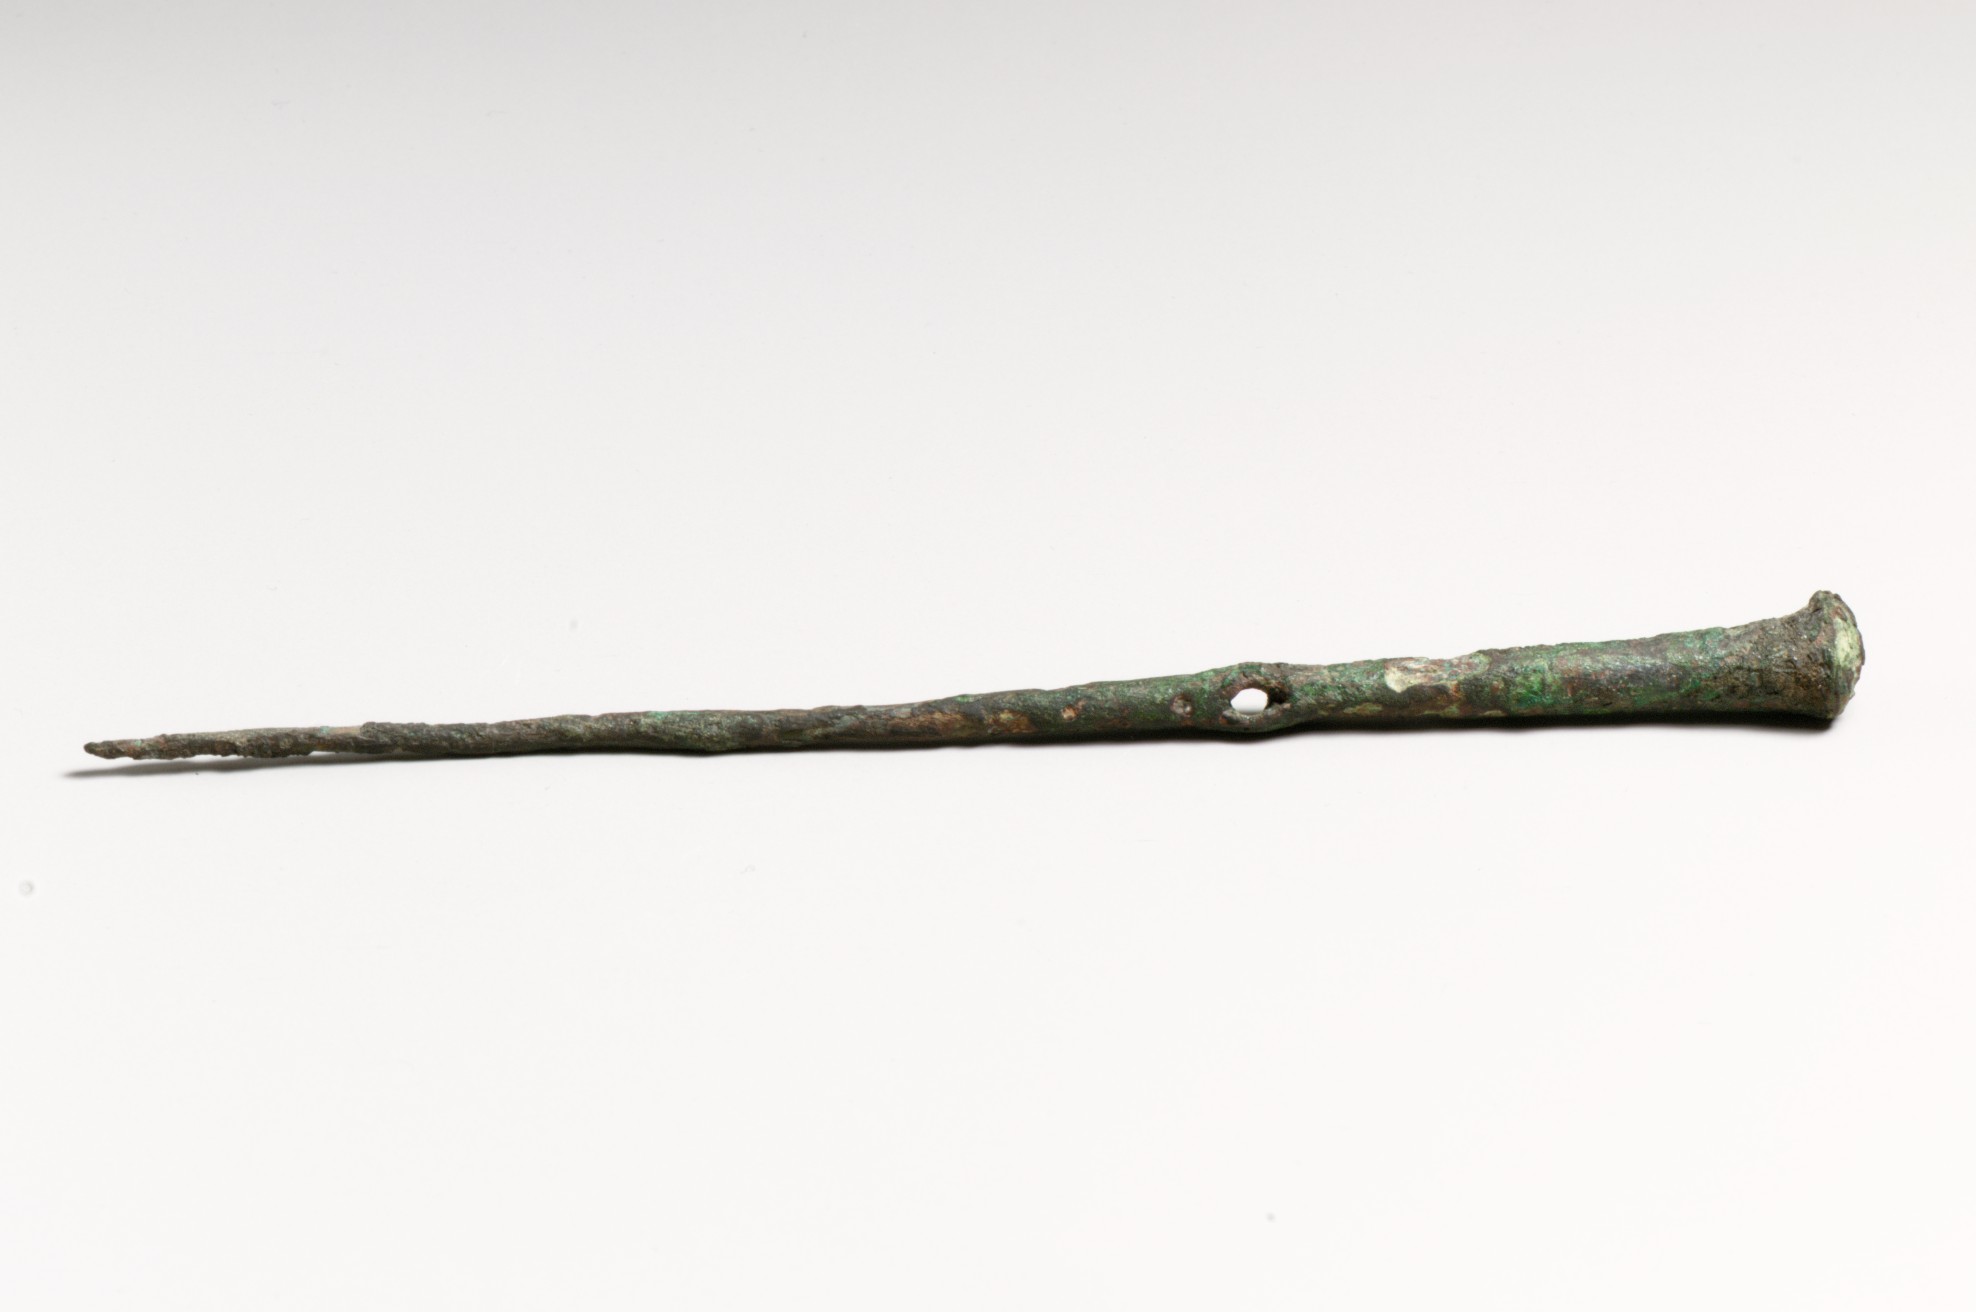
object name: pin, eyelet type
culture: cypriot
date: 3900 BCE-100 CE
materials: bronze